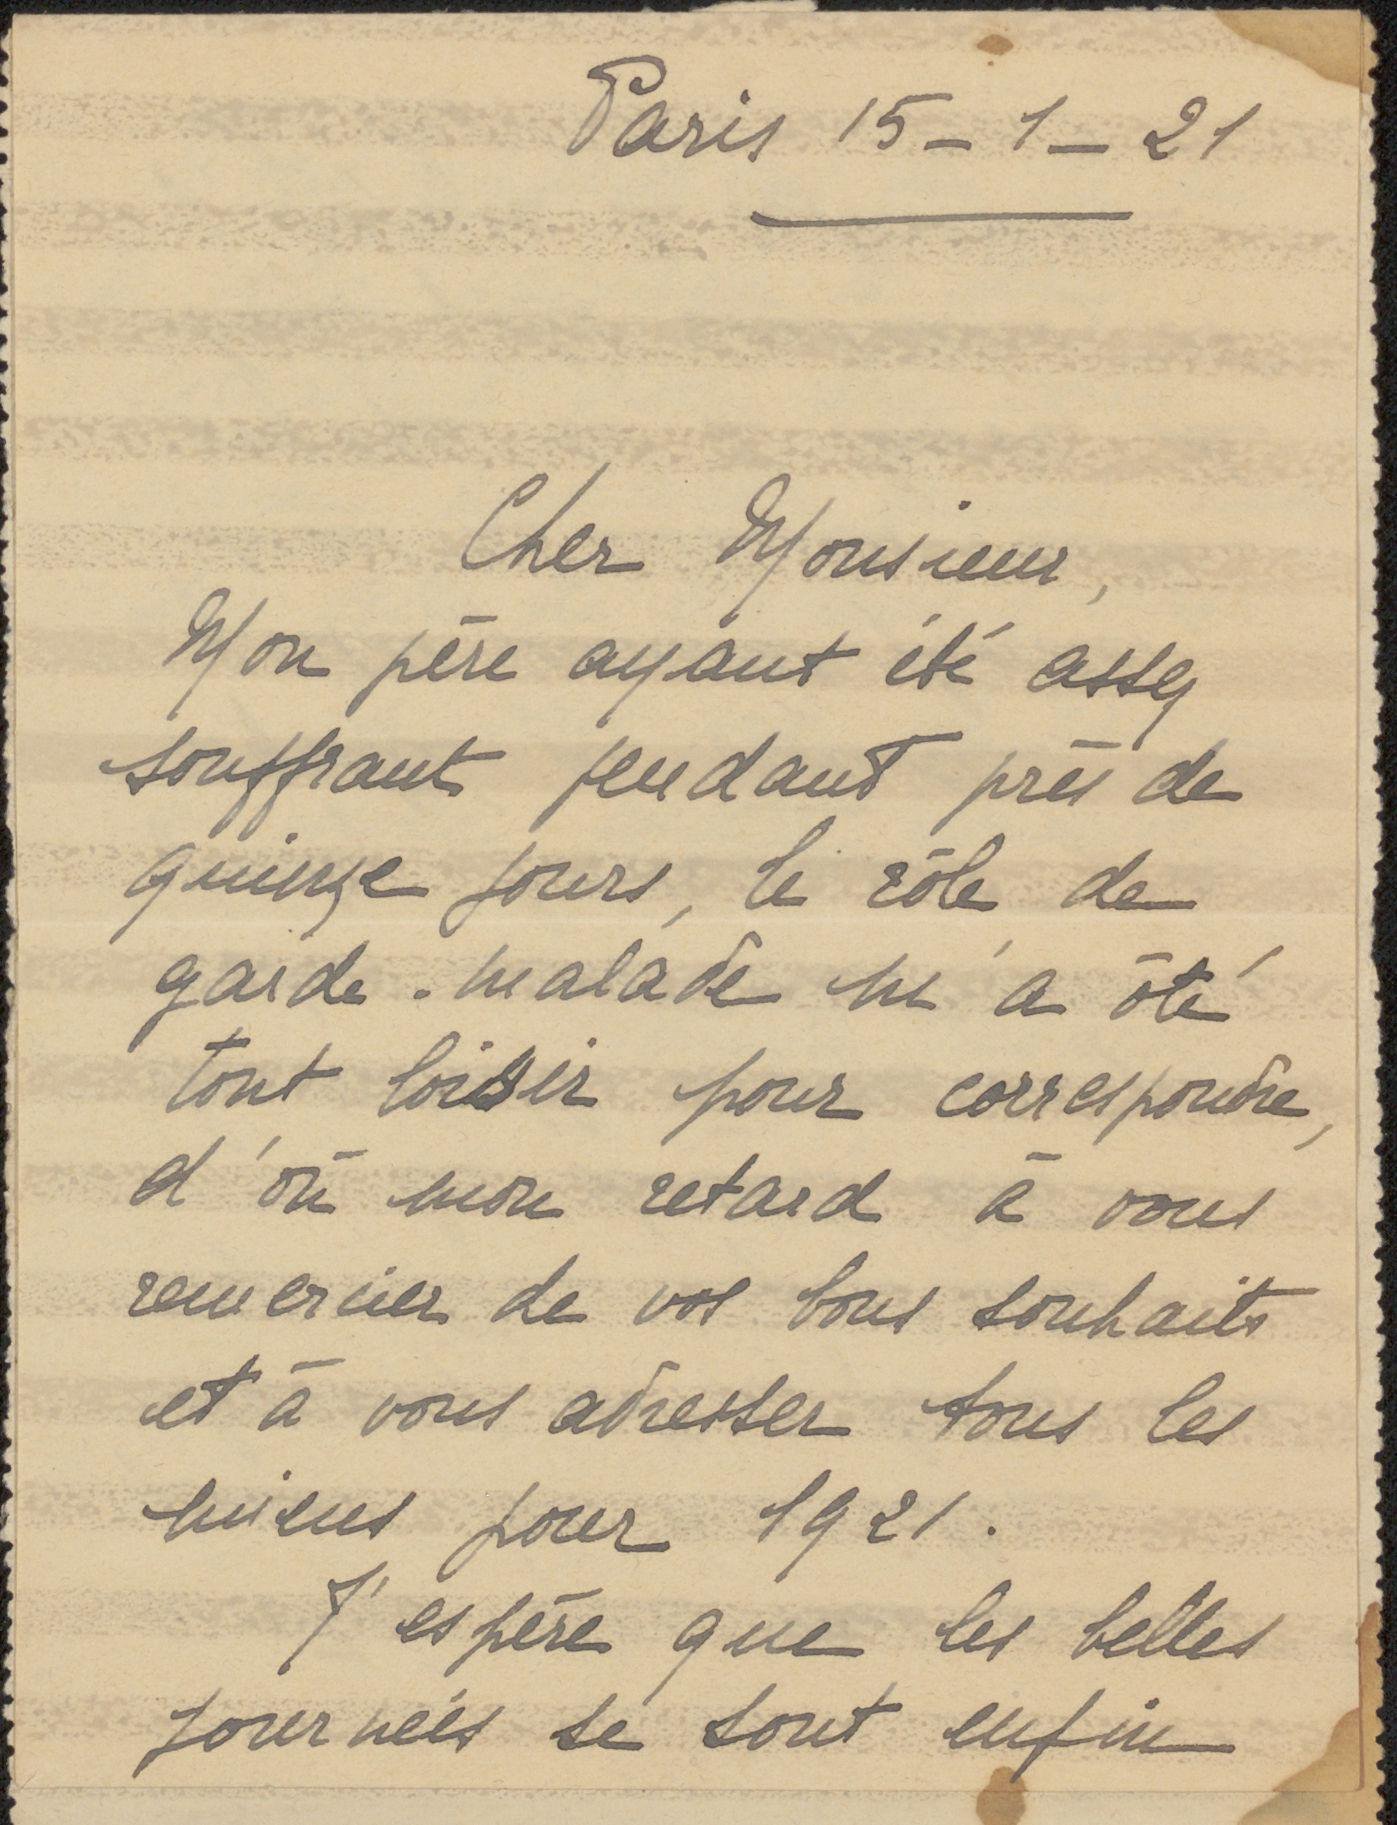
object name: letter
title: Brief aan Philip Zilcken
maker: mariette richard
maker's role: painter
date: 1921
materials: ink, paper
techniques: pen, writing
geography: paris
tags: the hague, philip zilcken, paris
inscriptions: collector's mark: ‘RPK’